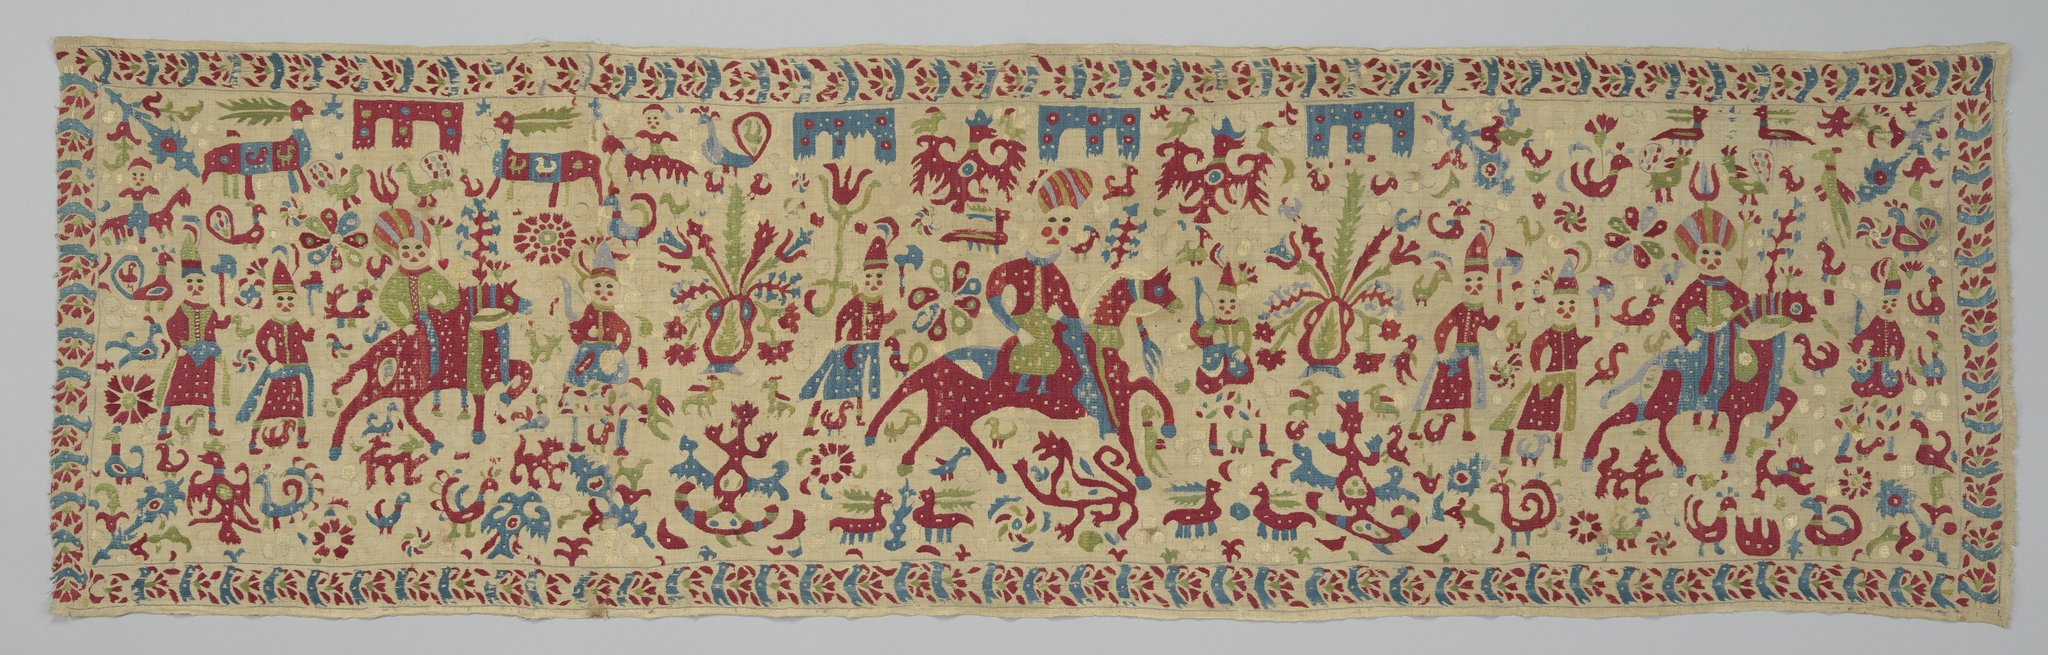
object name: valance fragment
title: Part of a valance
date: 1701-1800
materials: cotton, silk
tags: birds,men,horses